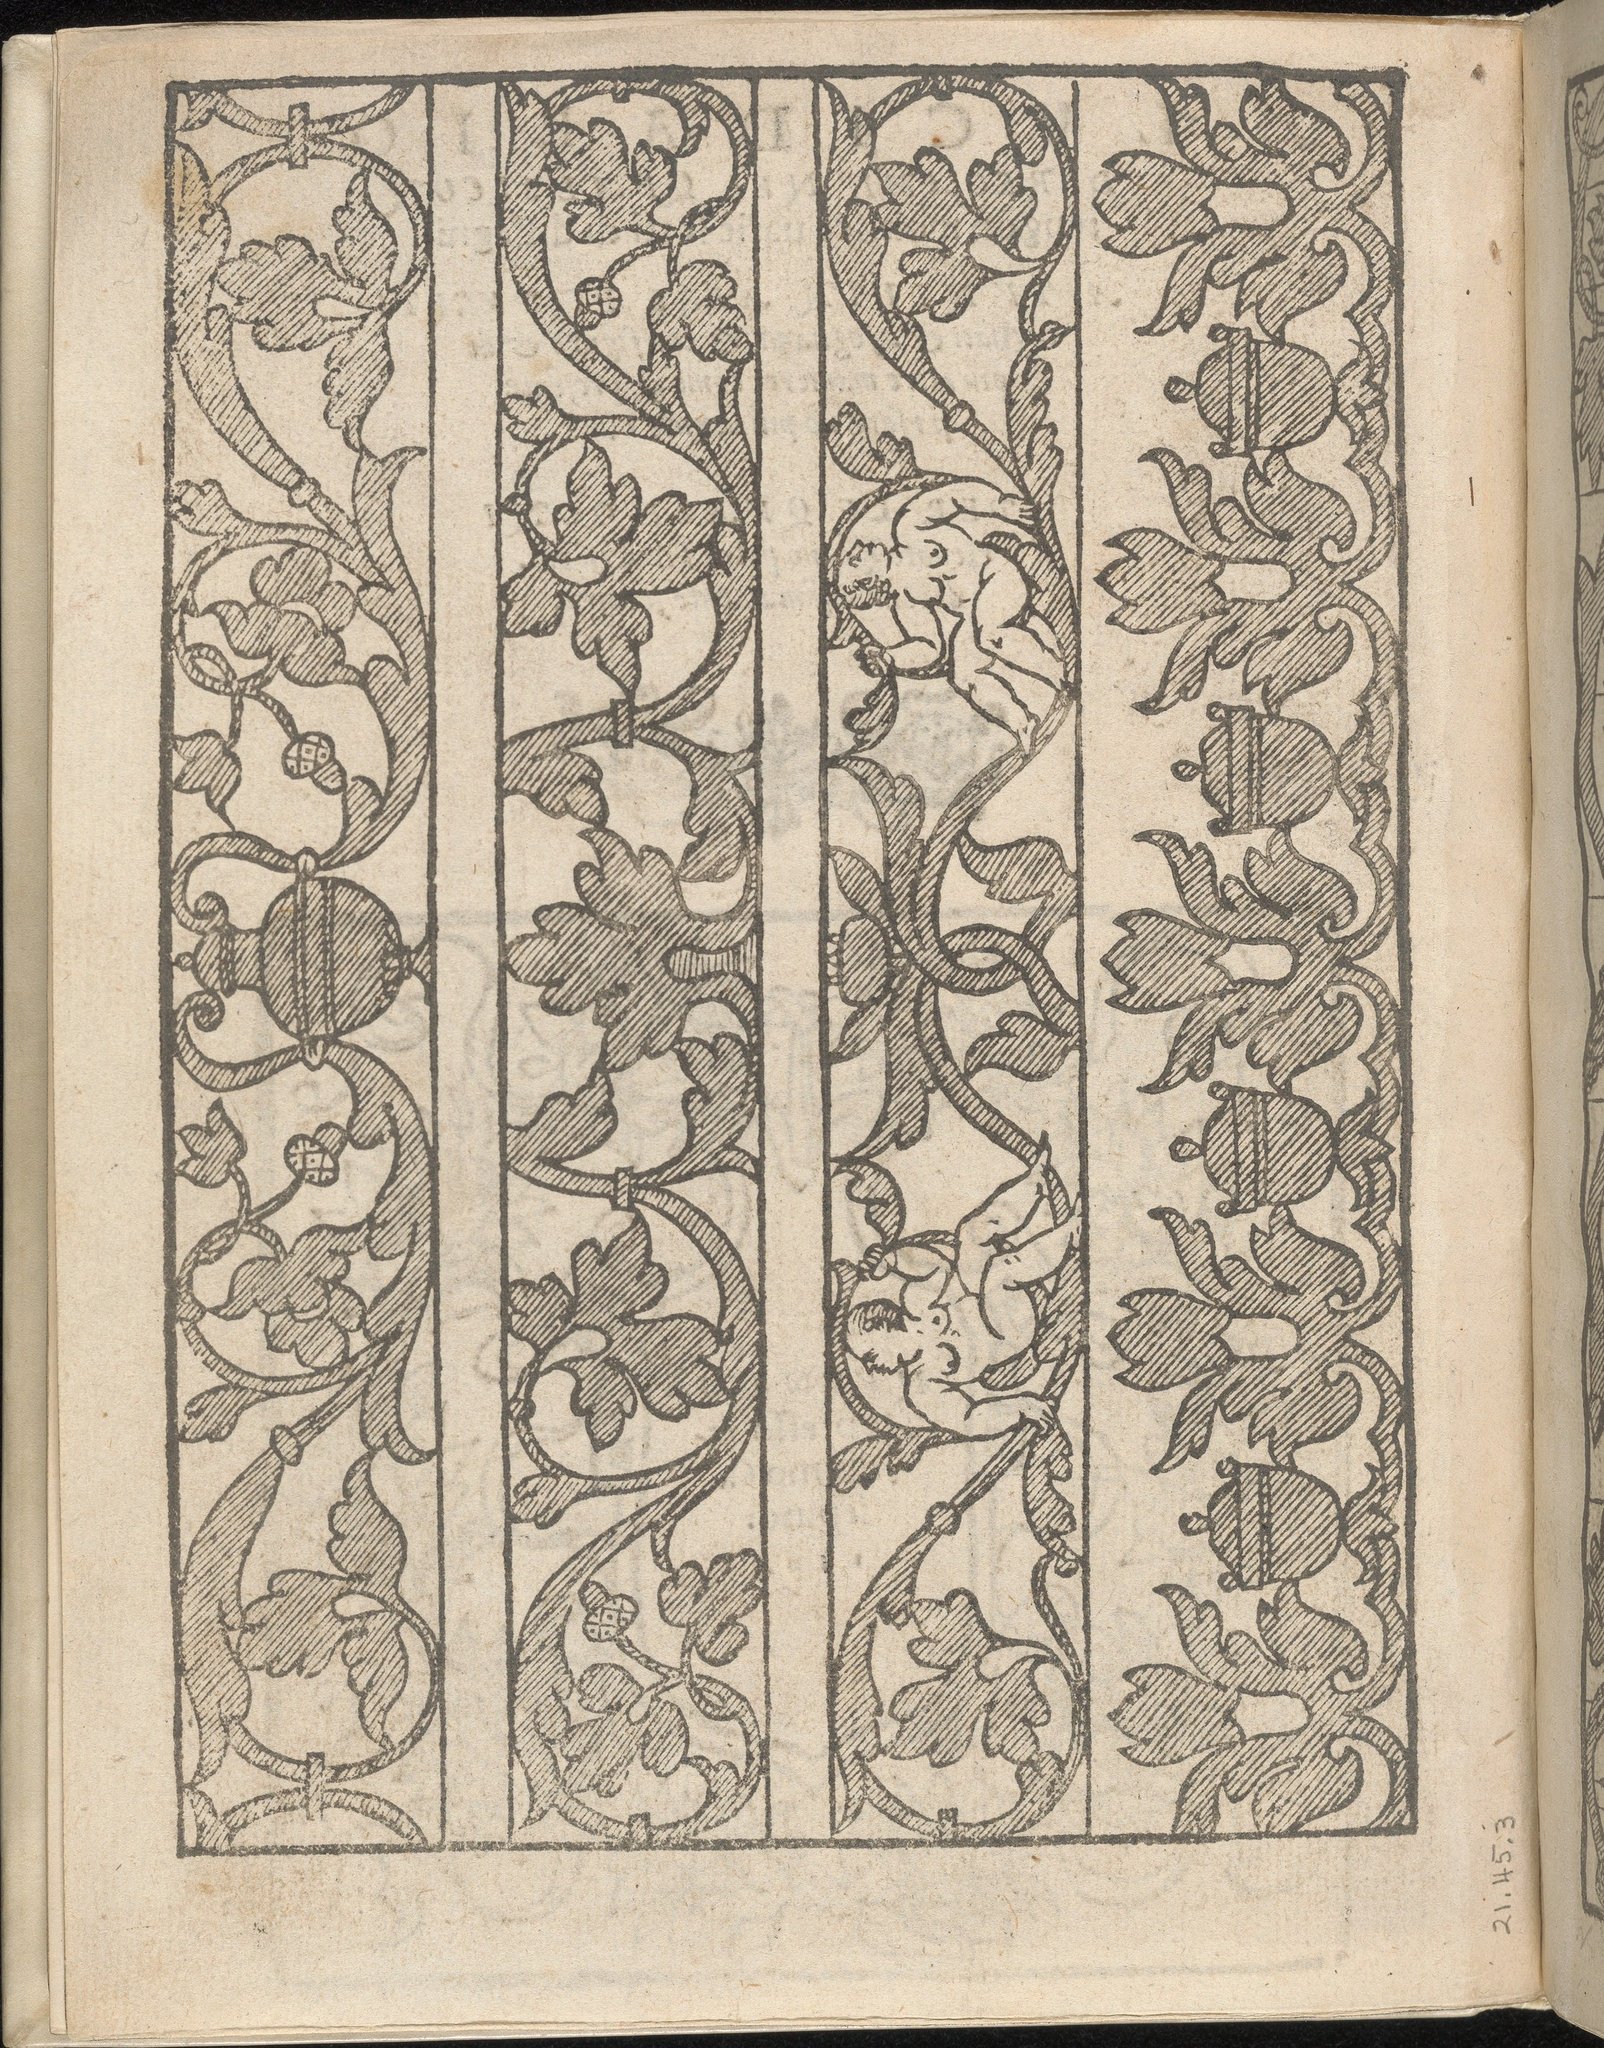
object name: book print ornament architecture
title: Lucidario di Recami, page 2 (recto)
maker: iseppo foresto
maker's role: designer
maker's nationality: italian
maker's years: 1520-1580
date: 1564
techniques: woodcut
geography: italy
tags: grapes,flowers,vines